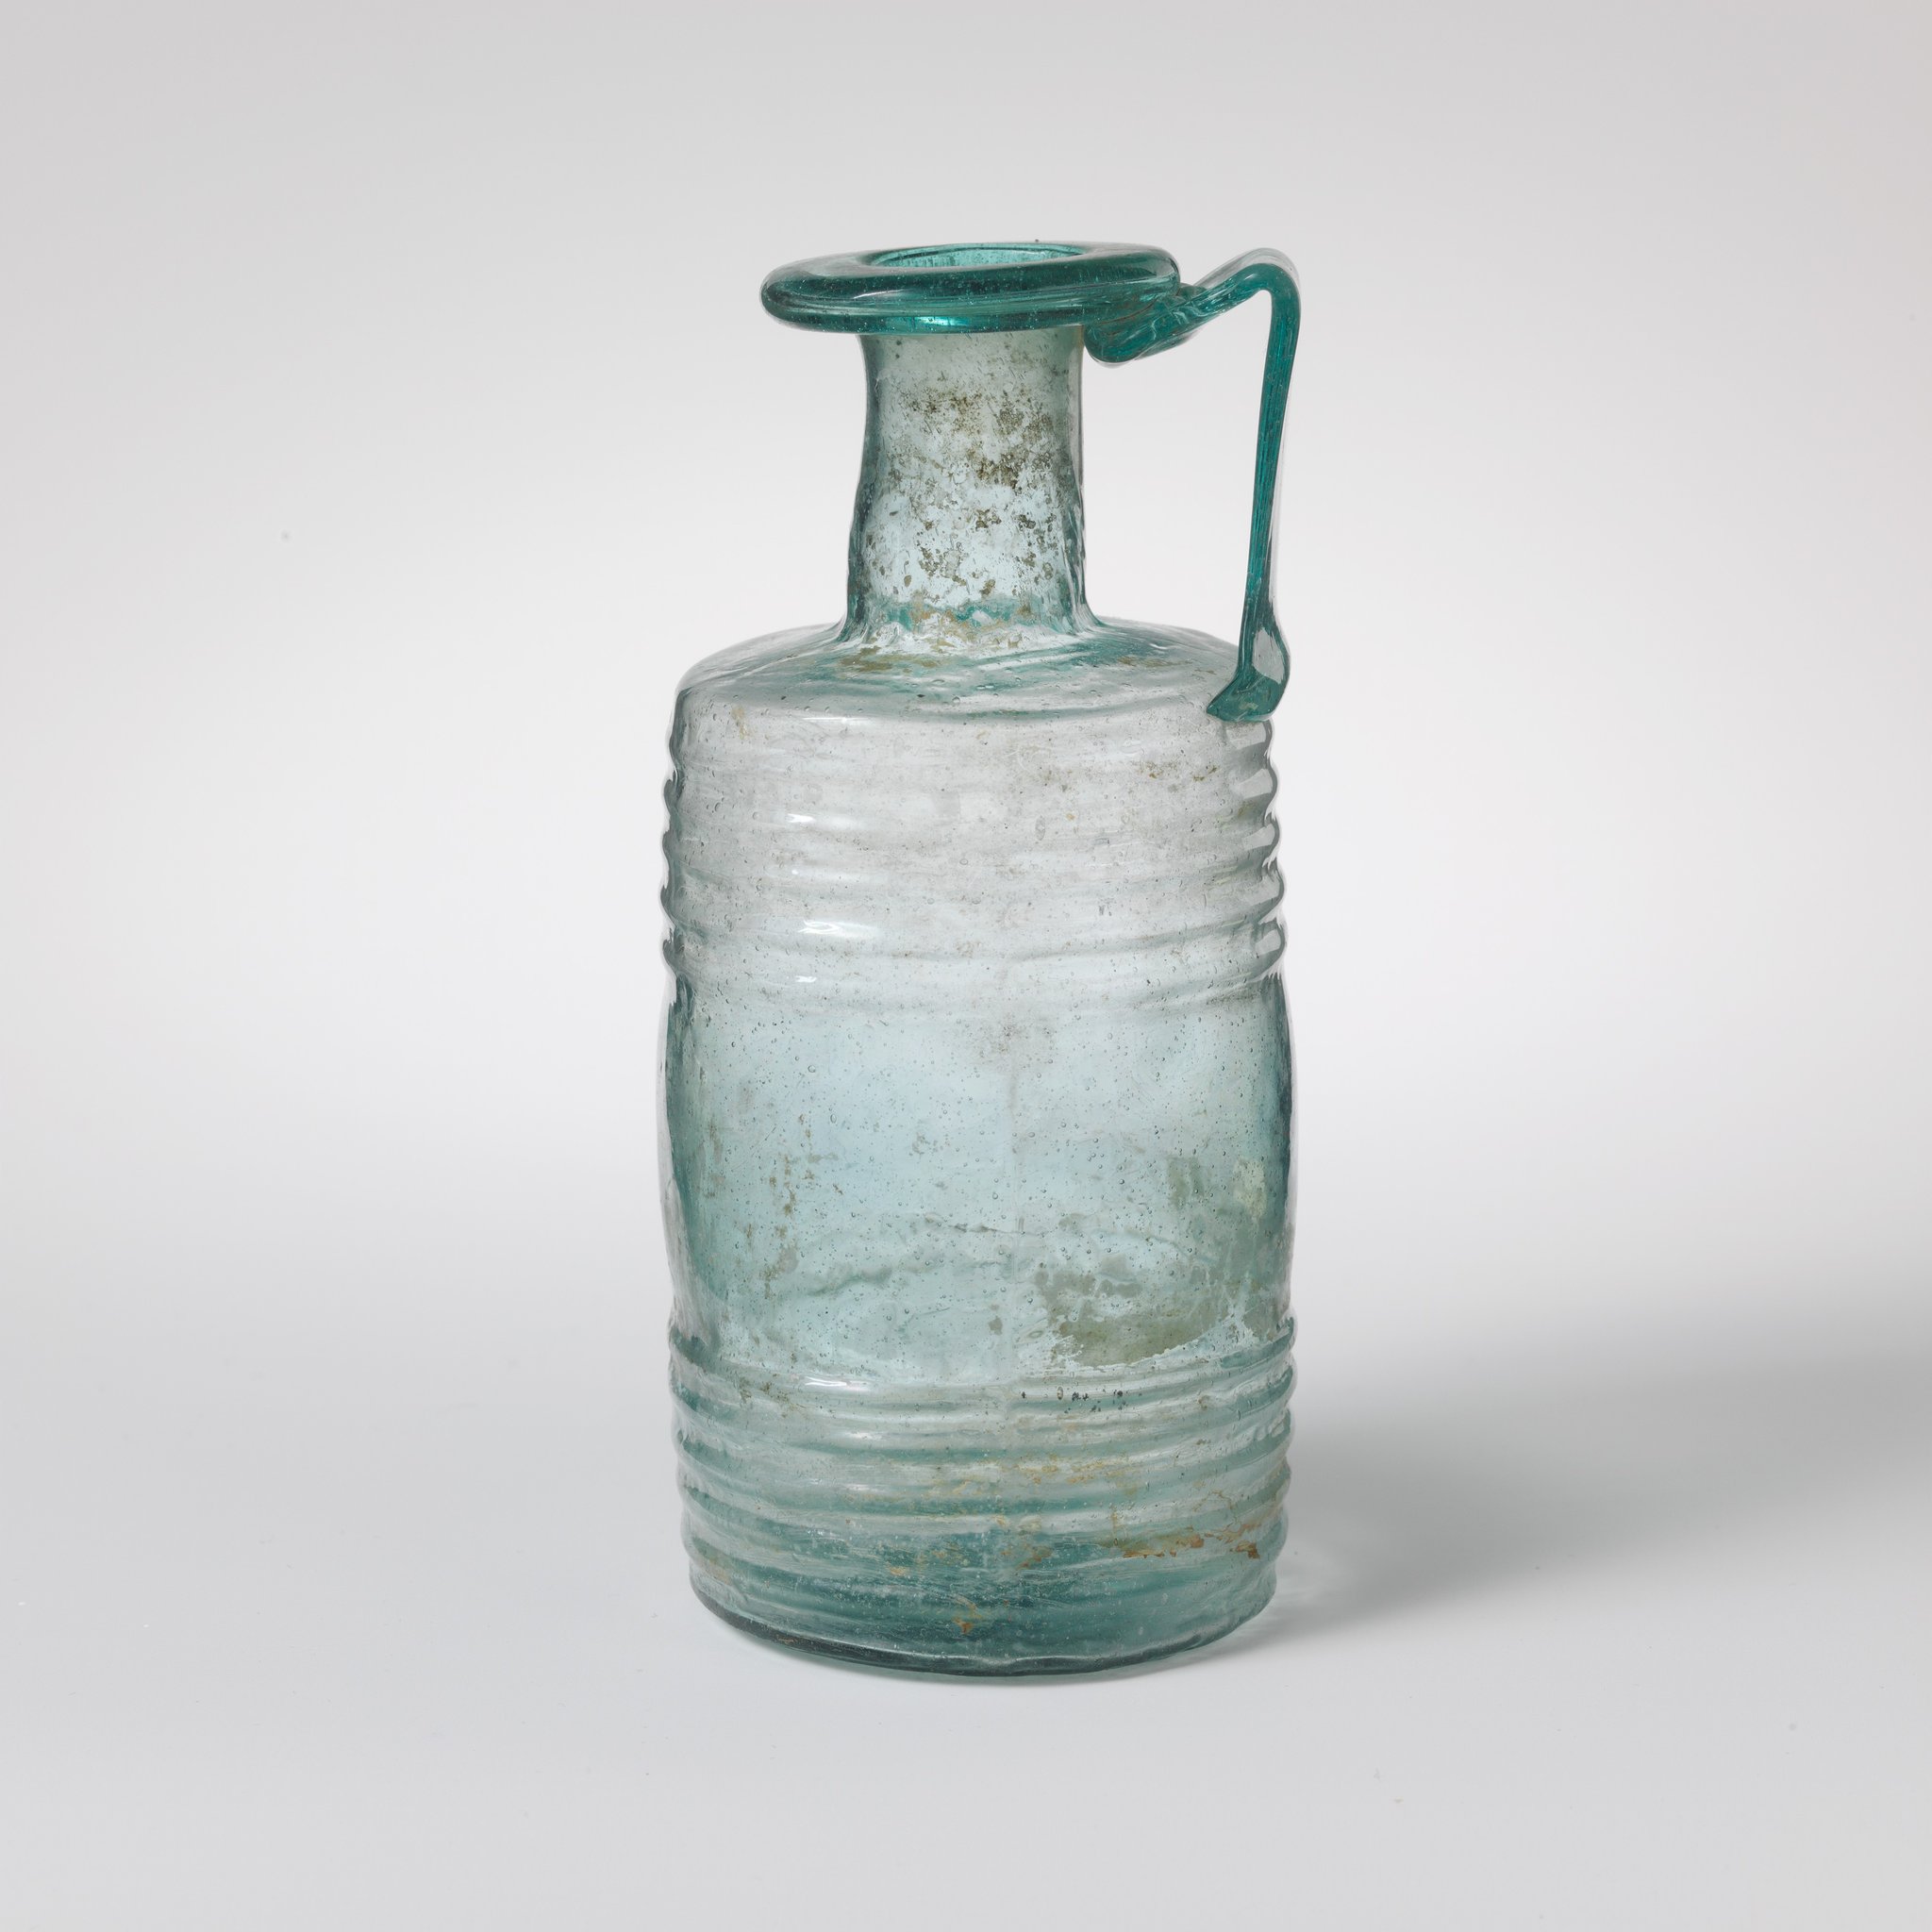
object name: jug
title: Glass barrel jug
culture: roman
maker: frontinus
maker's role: artist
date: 201-300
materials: glass